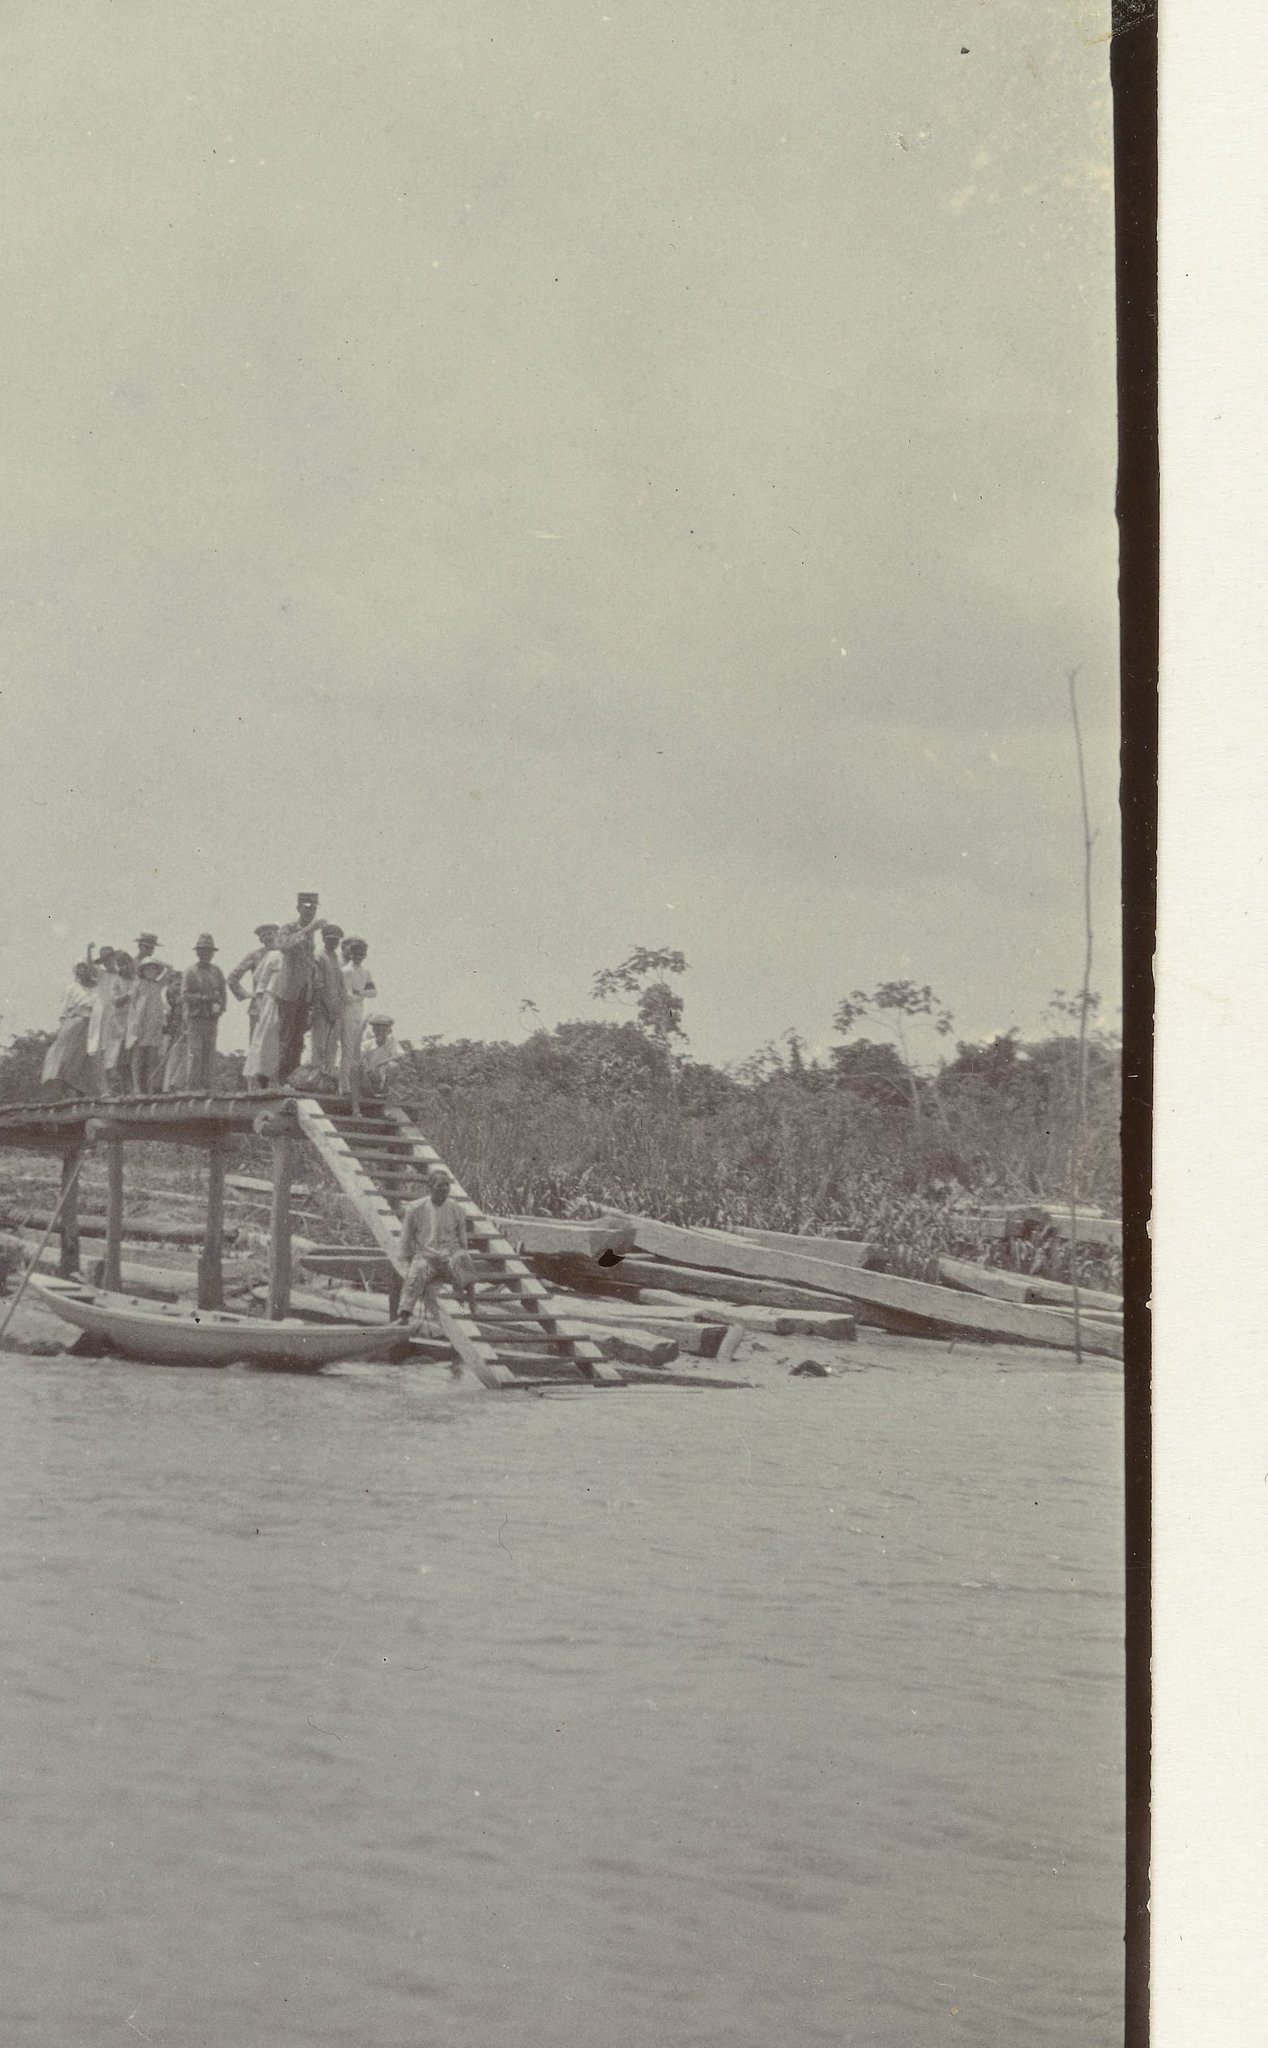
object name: photograph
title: Steiger van de plantage Accaribo, Suriname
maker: theodoor brouwers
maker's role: amateurfotograaf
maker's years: 1874-1932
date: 1911-1932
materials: photographic support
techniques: photography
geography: suriname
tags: theodoor brouwers, suriname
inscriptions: inscription: ‘Stijger Accaribo’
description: In de periode 1911-1932 woonde op plantage Accaribo in Suriname de familie Brouwers van wie de foto's afkomstig zijn. Rond 1910 vond Theodoor Brouwers werk op plantage Accaribo. In 1929 werd hij eigenaar van de plantage.